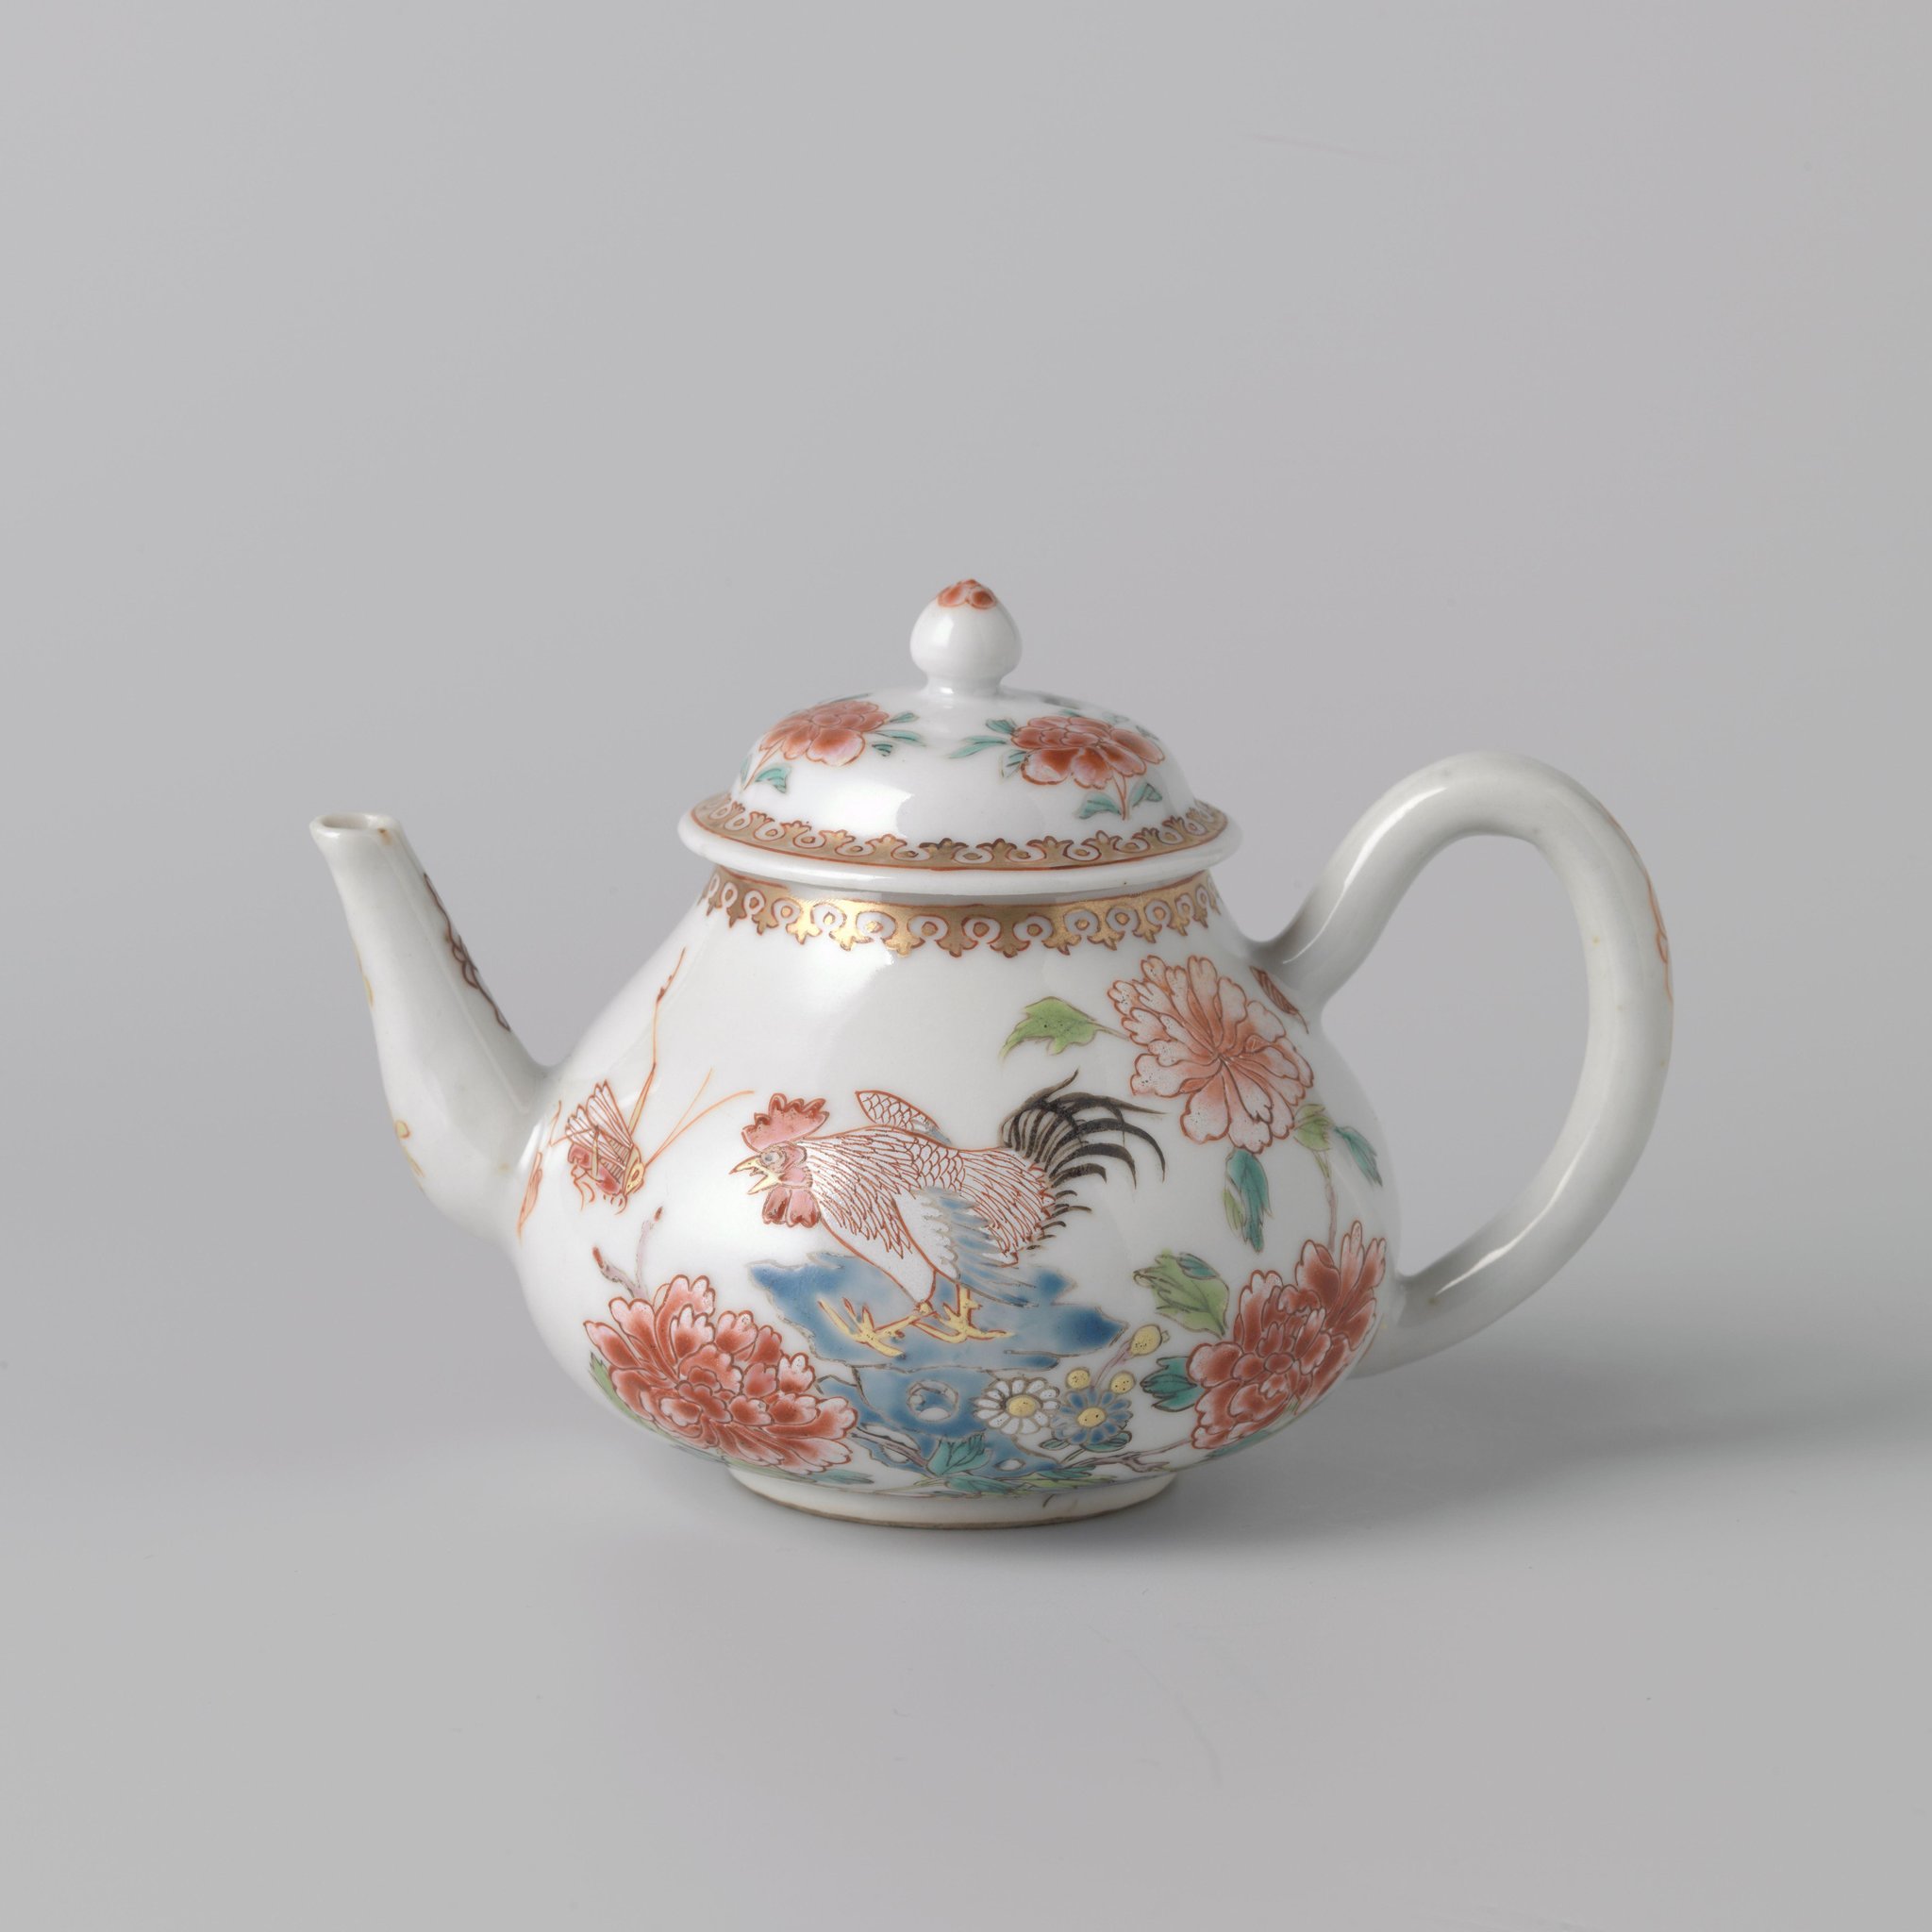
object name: teapot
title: Teapot with a cock on a rock near flowering plants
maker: Anonymous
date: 1725-1749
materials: glaze, gold, paint, porcelain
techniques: firing, gilding, turning, vitrification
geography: china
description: Peervormige theepot van porselein, beschilderd op het glazuur in blauw, rood, groen, geel, zwart en goud. Op de wand tweemaal een haan op een rots bij bloeiende planten (pioen, aster) met daarnaast een insect. Op de rand een 'spearhead-border'. Het oor en de tuit met losse bloemen en een wolkmotief. Famille rose.